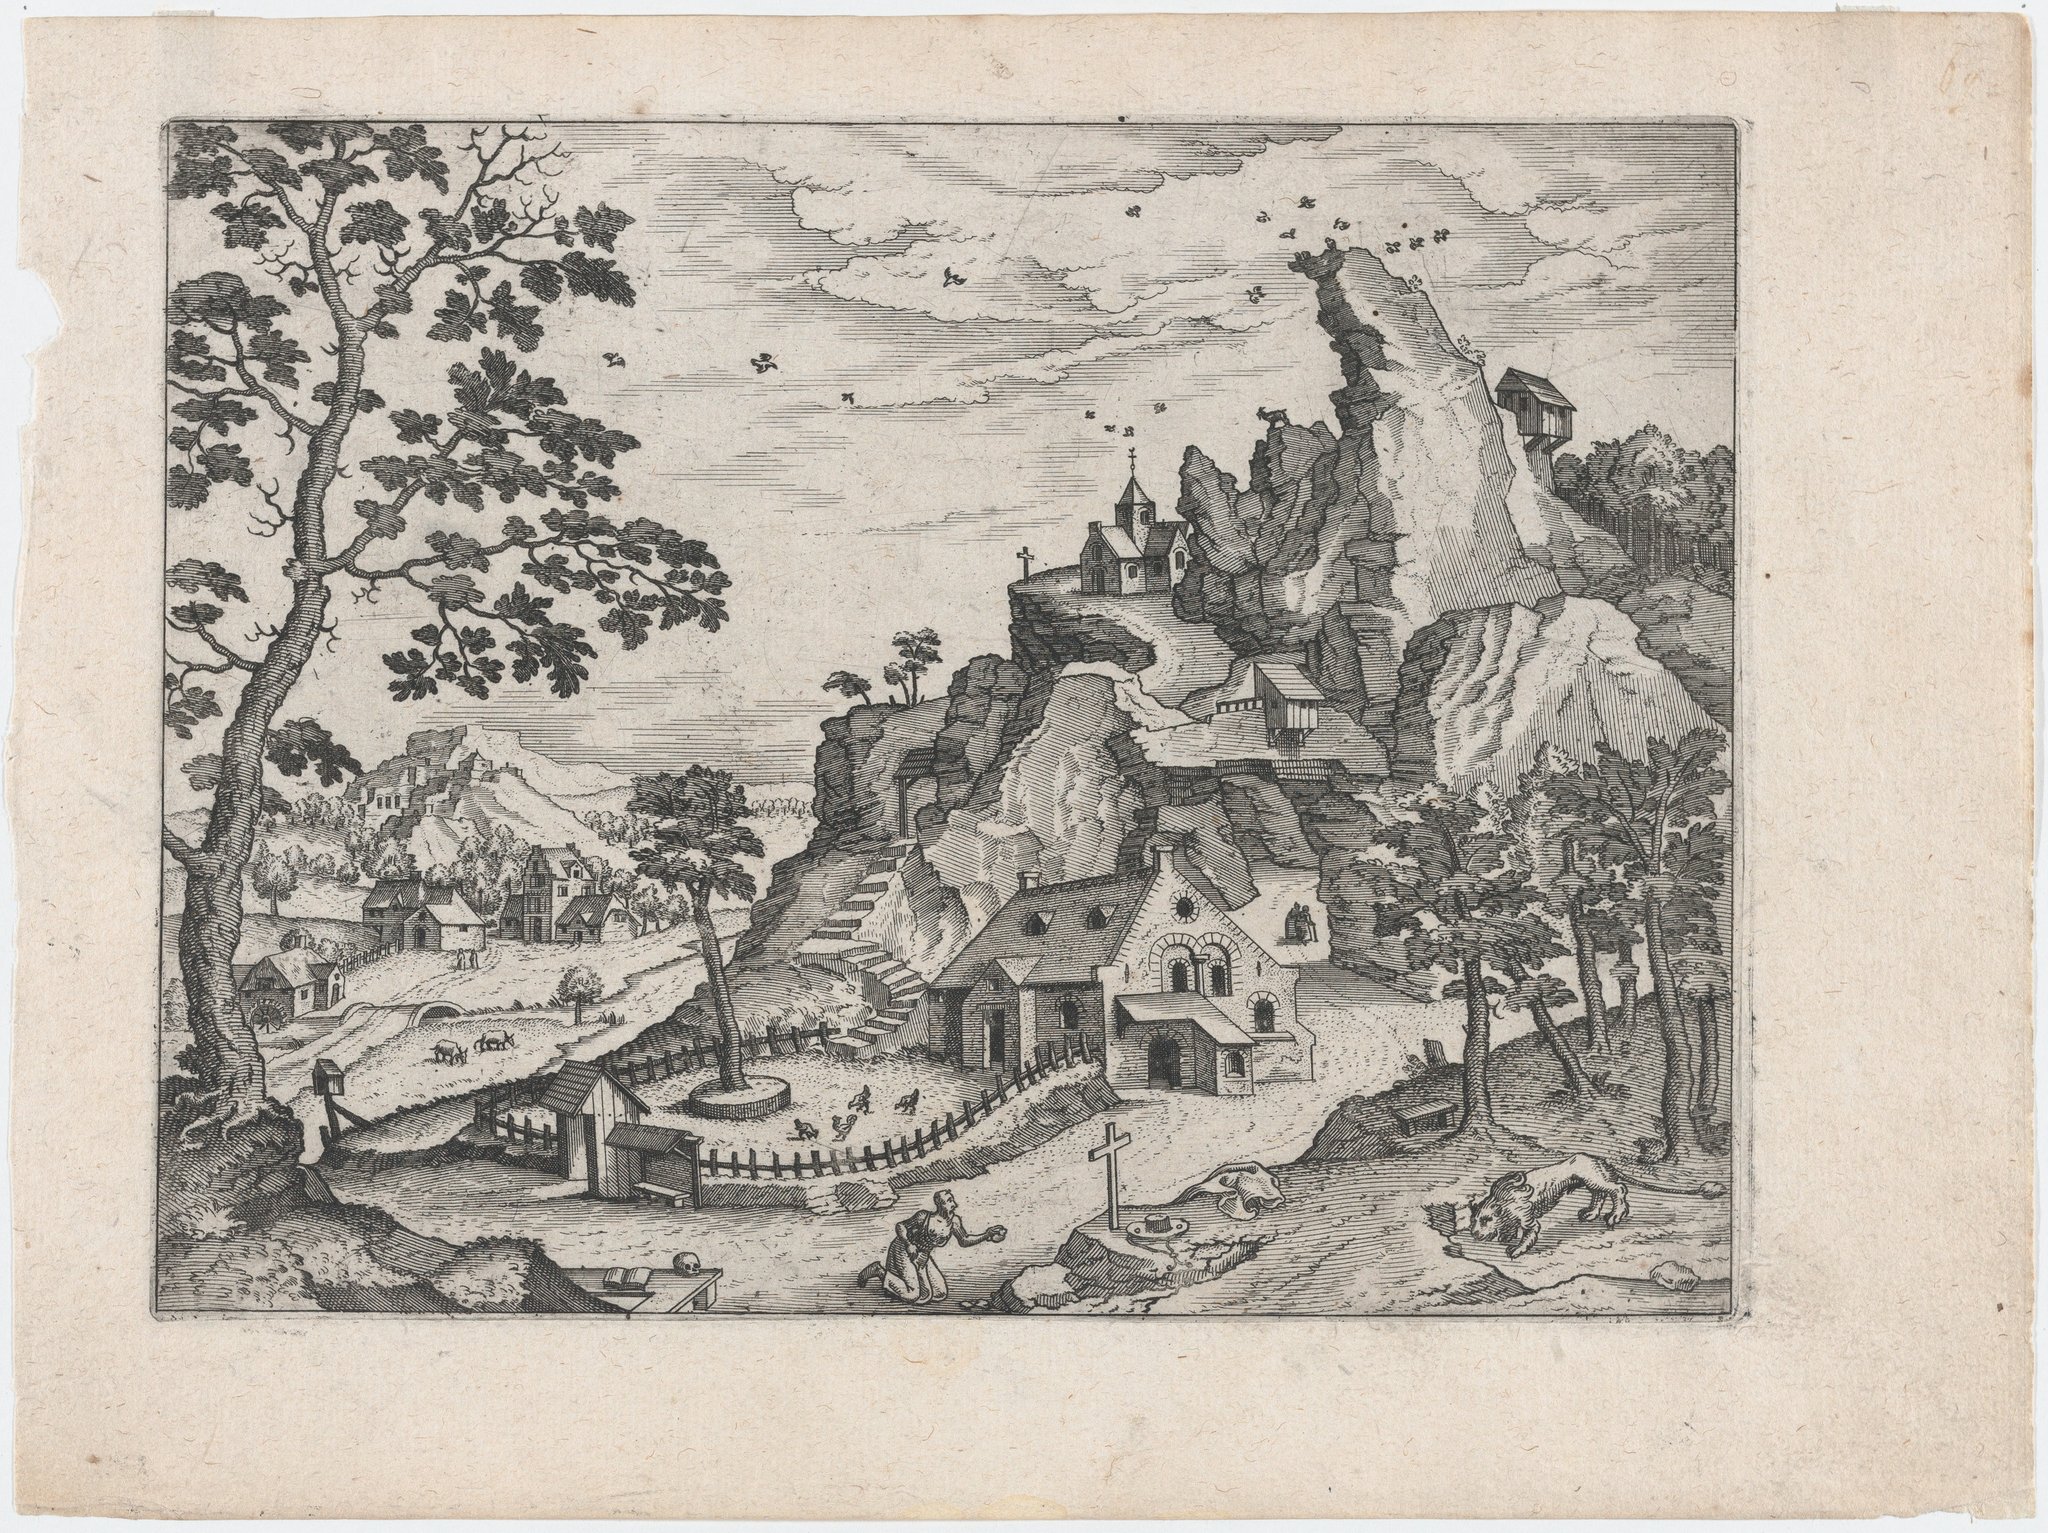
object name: print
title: Landscape with Saint Jerome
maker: lucas gassel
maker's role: artist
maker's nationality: netherlandish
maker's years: 1495-1500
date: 1560-1570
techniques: engraving, etching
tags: houses,landscapes,trees,saint jerome,cross